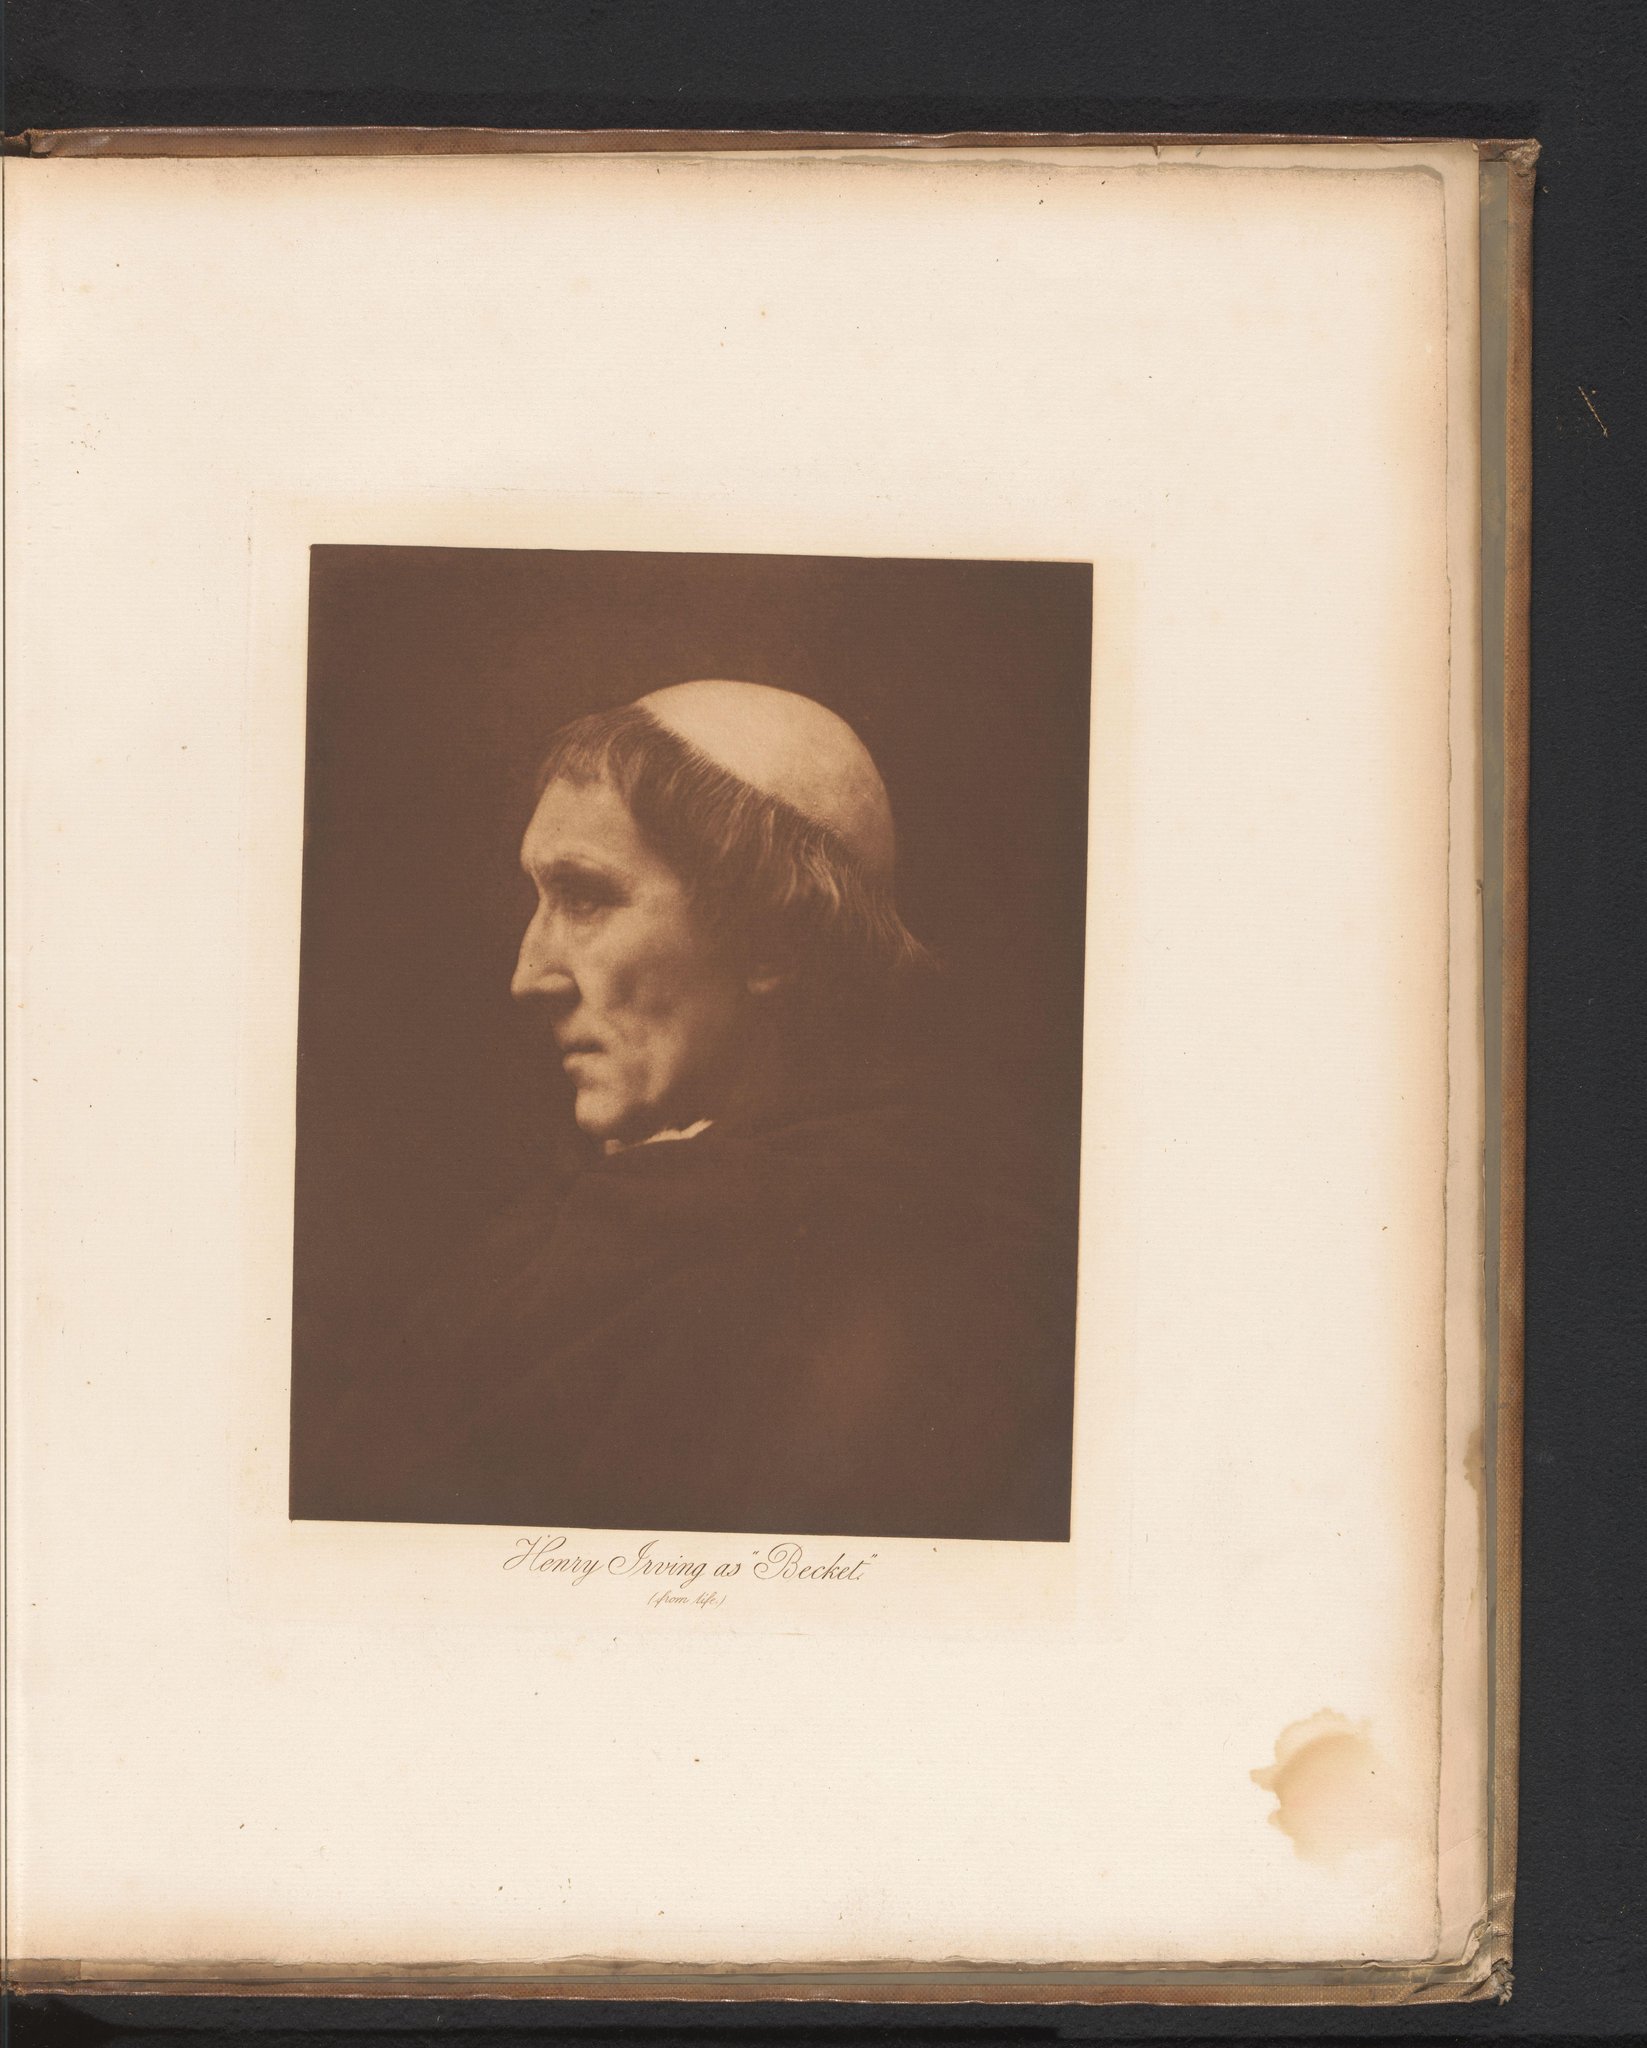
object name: page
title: Henry Irving as "Becket"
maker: henry herschel hay cameron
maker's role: fotograaf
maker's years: 1852-1911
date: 1888-1893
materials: paper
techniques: photoaquatint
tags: historical persons, portrait of actor, actress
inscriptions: inscription: ‘Henry Irving as "Becket"./ (from life.)’